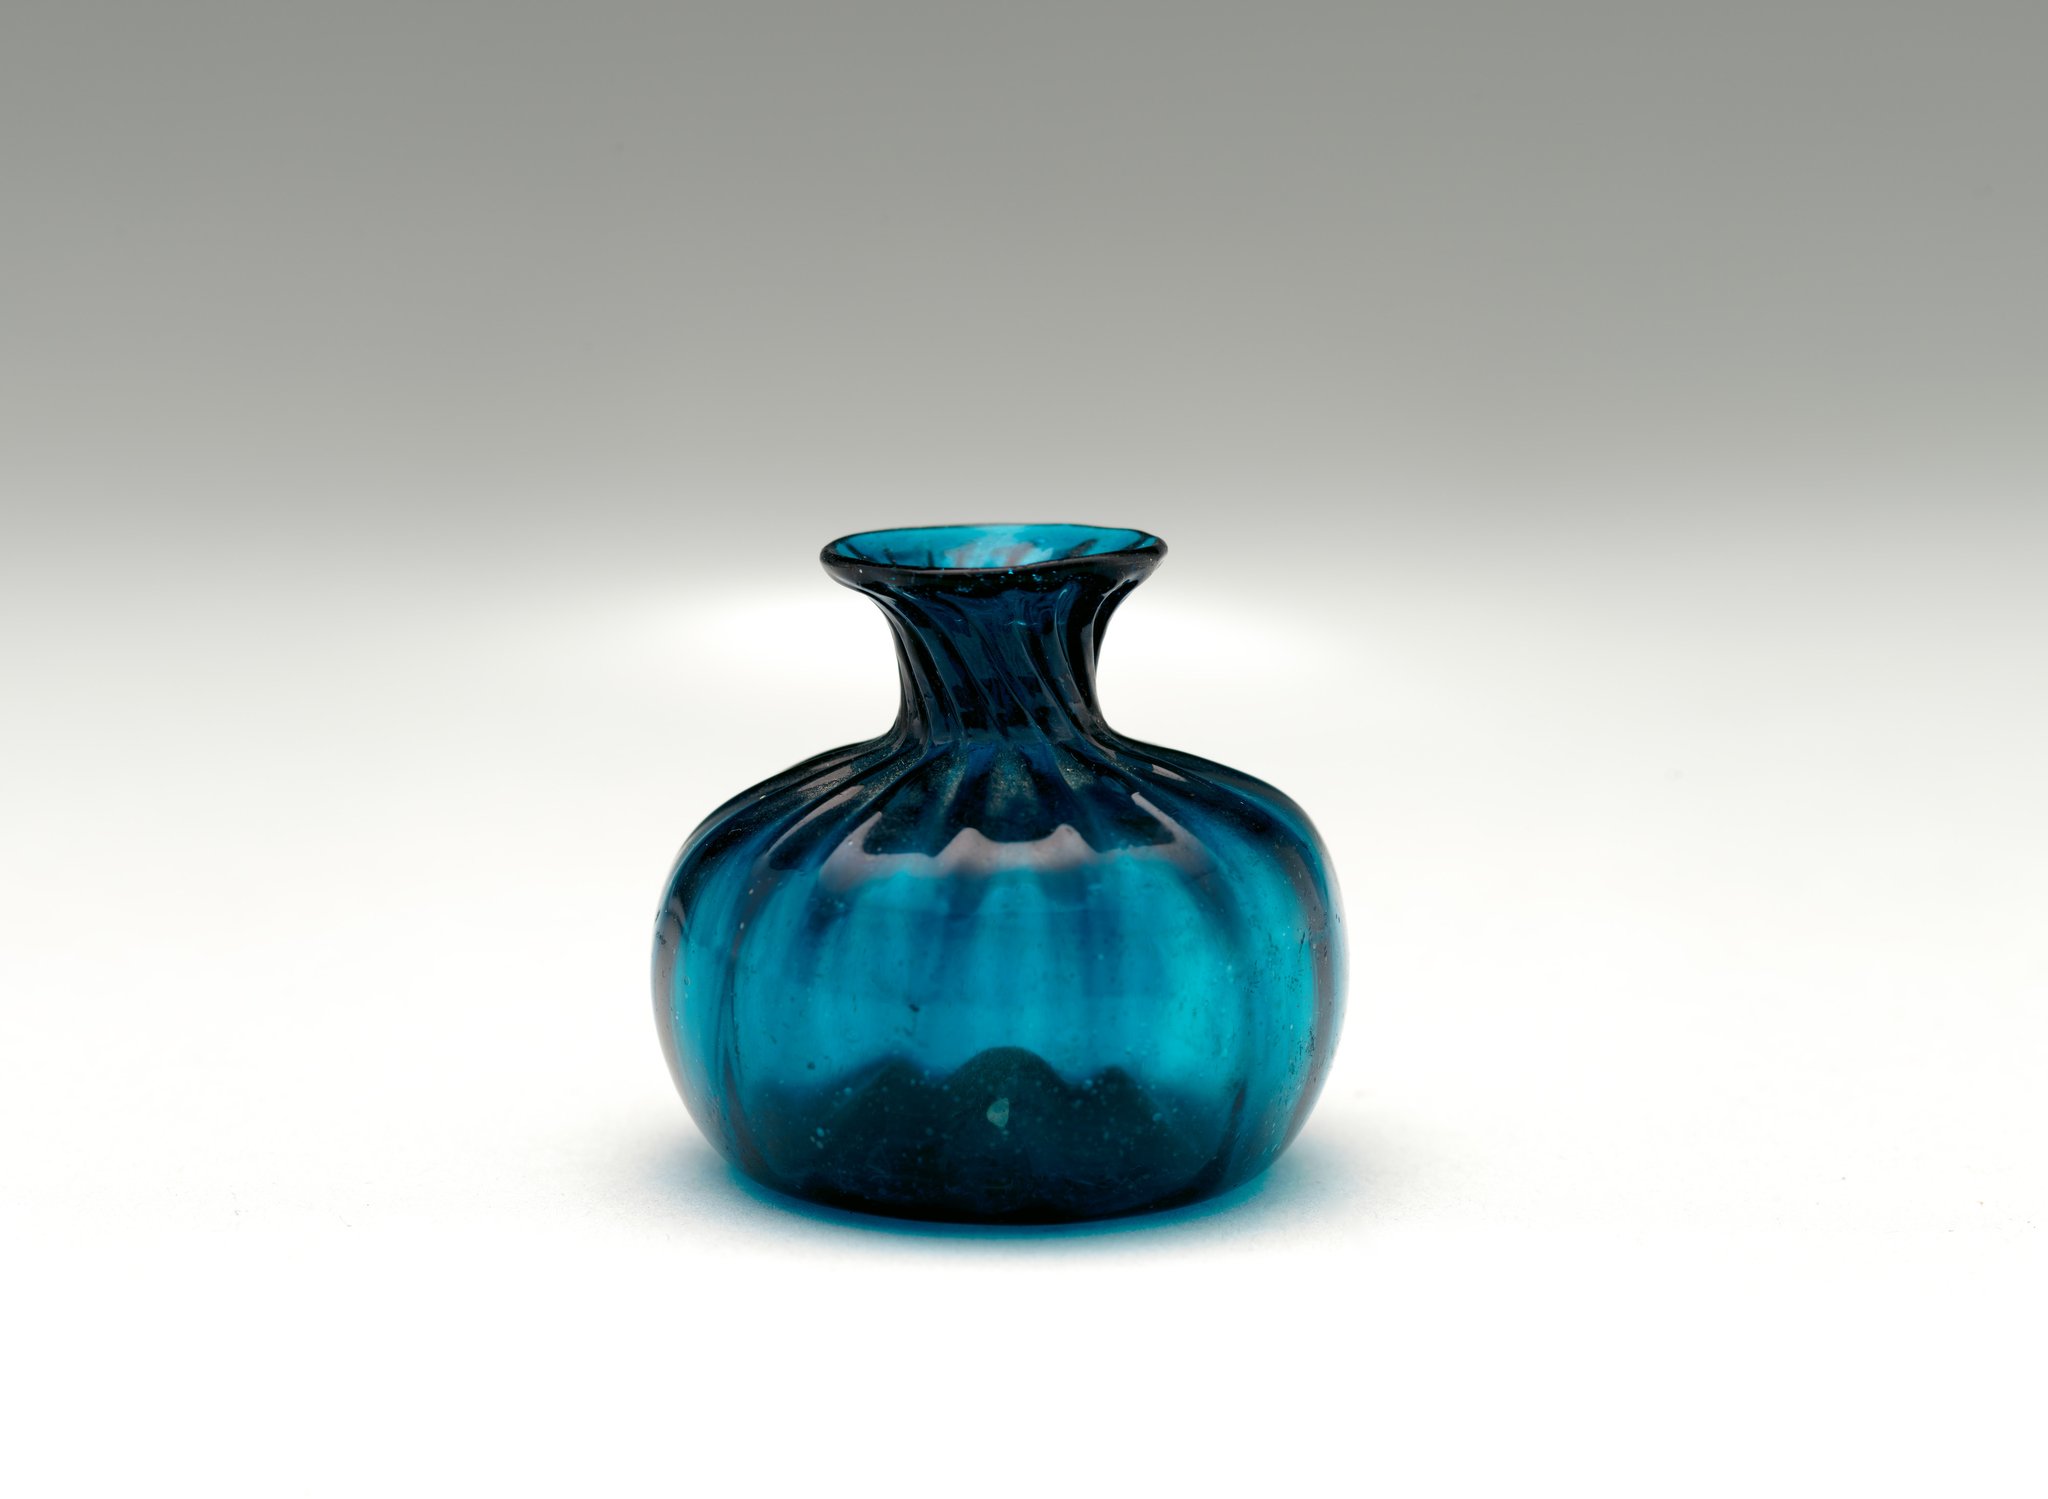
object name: bottle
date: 1801-1900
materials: glass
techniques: glassblowing, tooling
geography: iran